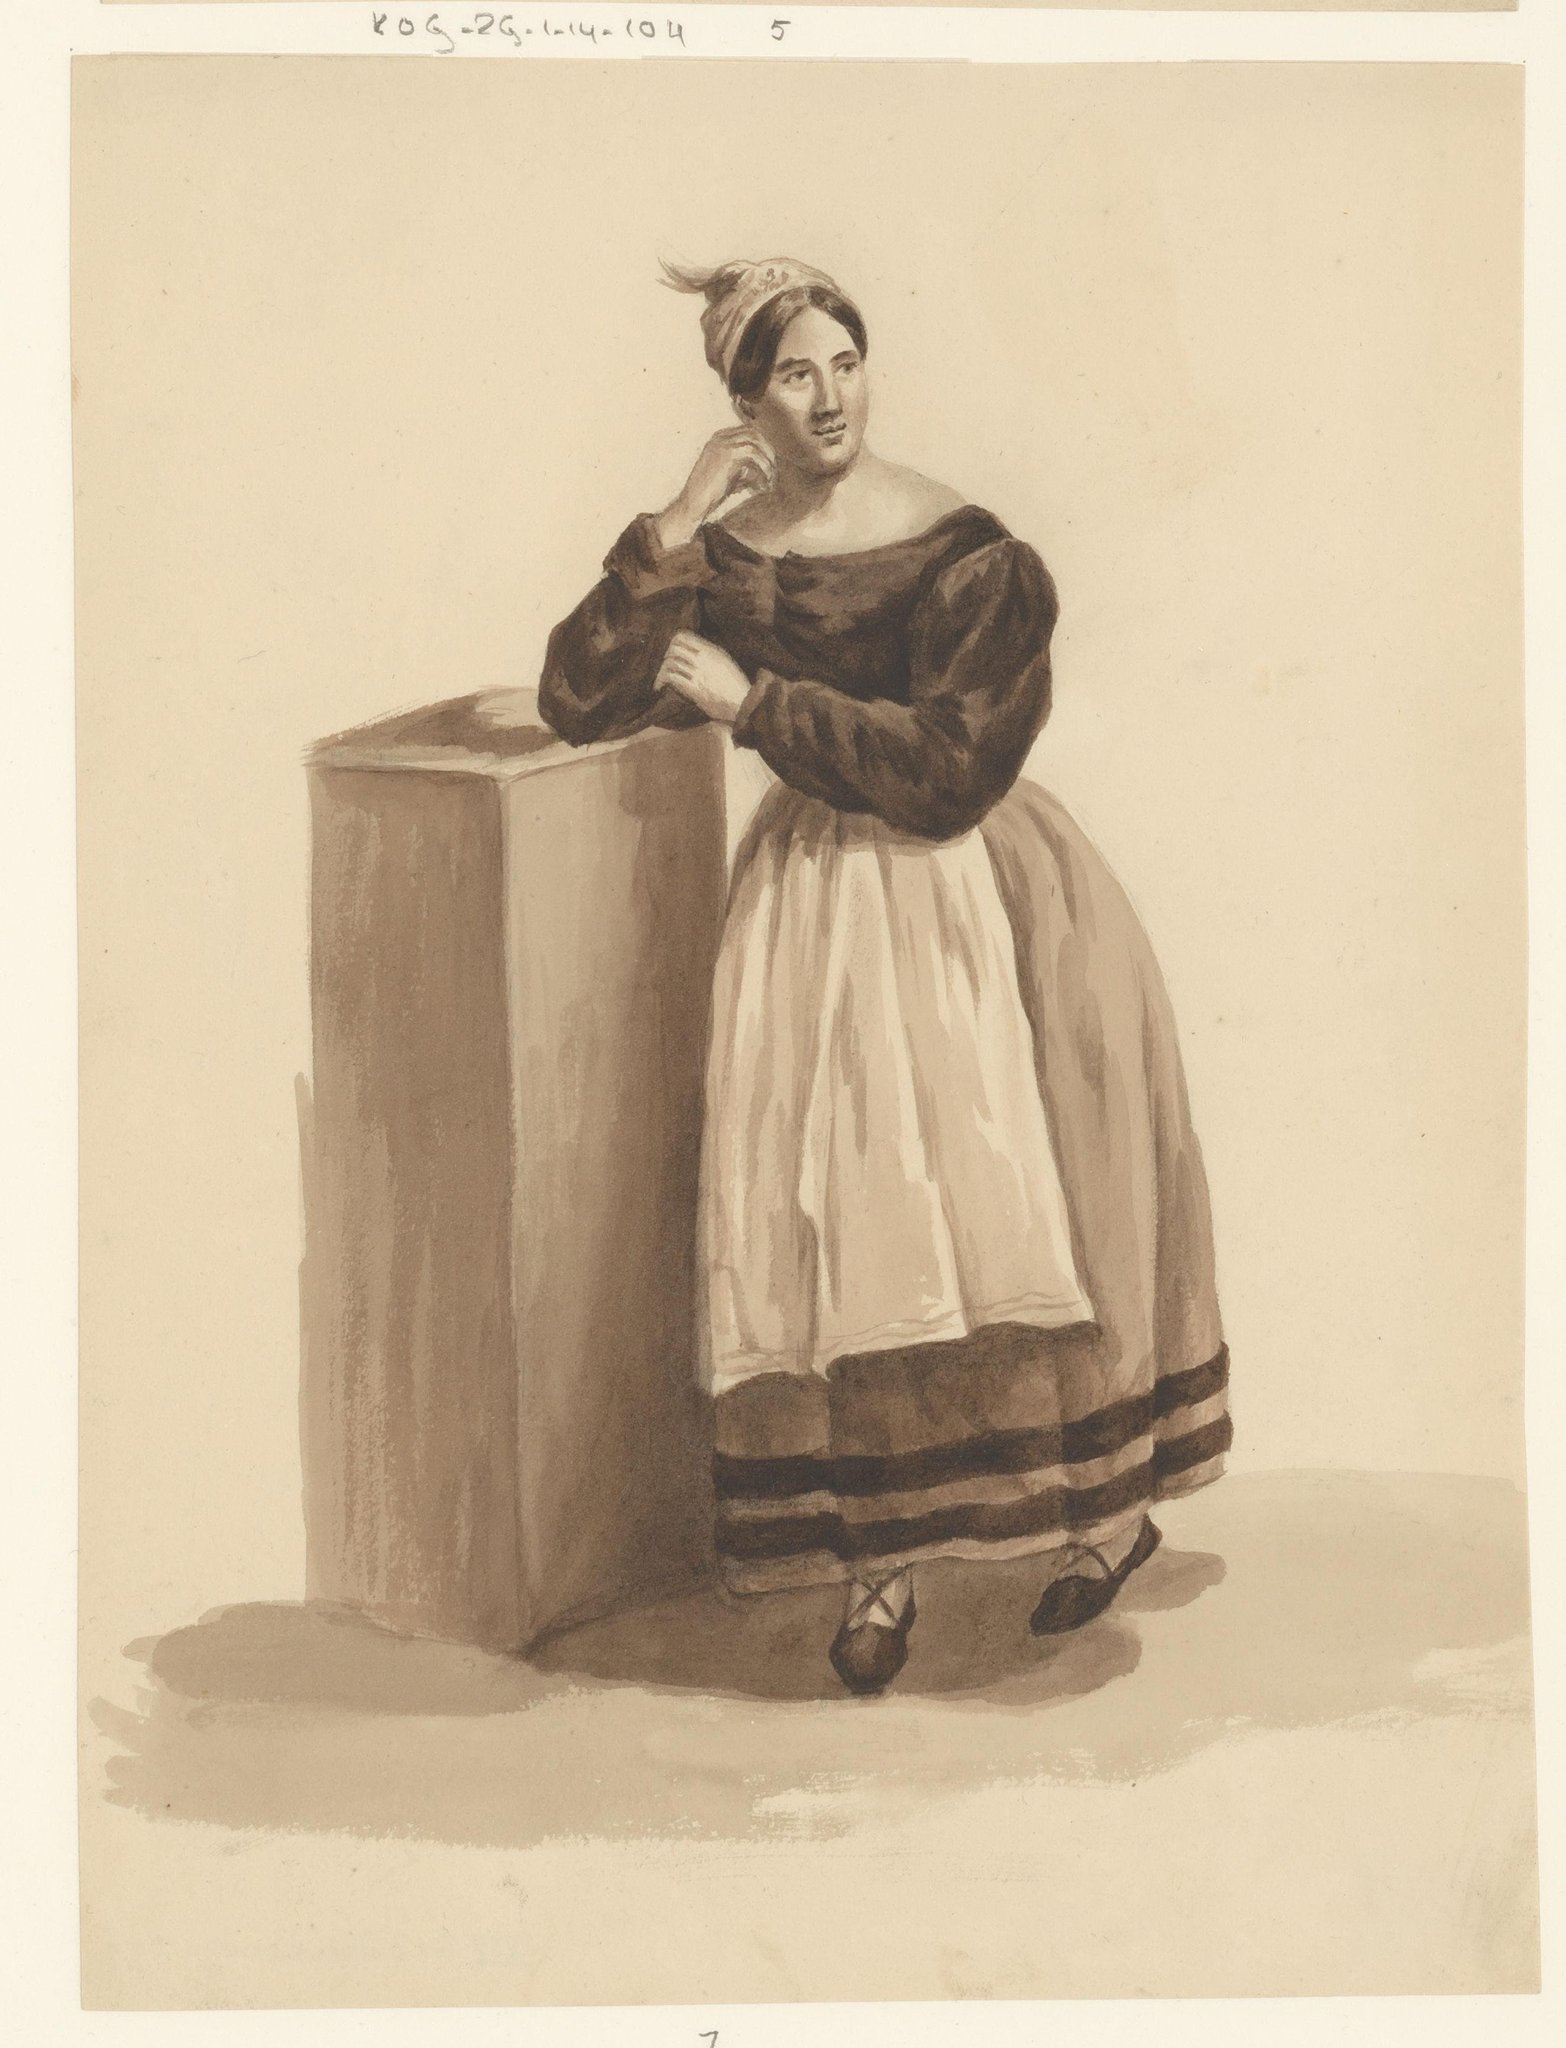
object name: drawing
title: Staande vrouw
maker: Anonymous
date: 1800-1850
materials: ink, paper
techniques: brush, pen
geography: netherlands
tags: standing figure - aa - female human figure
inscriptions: collector's mark, collector's mark: Lugt 1641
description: Een staande vrouw met een mutsje op het hoofd. Onderwerpsrubrieken binnen de Atlas Zeden en Gewoonten: Beroep en bedrijf. Vrouwelijk beroep en bedrijf. Dienstboden.